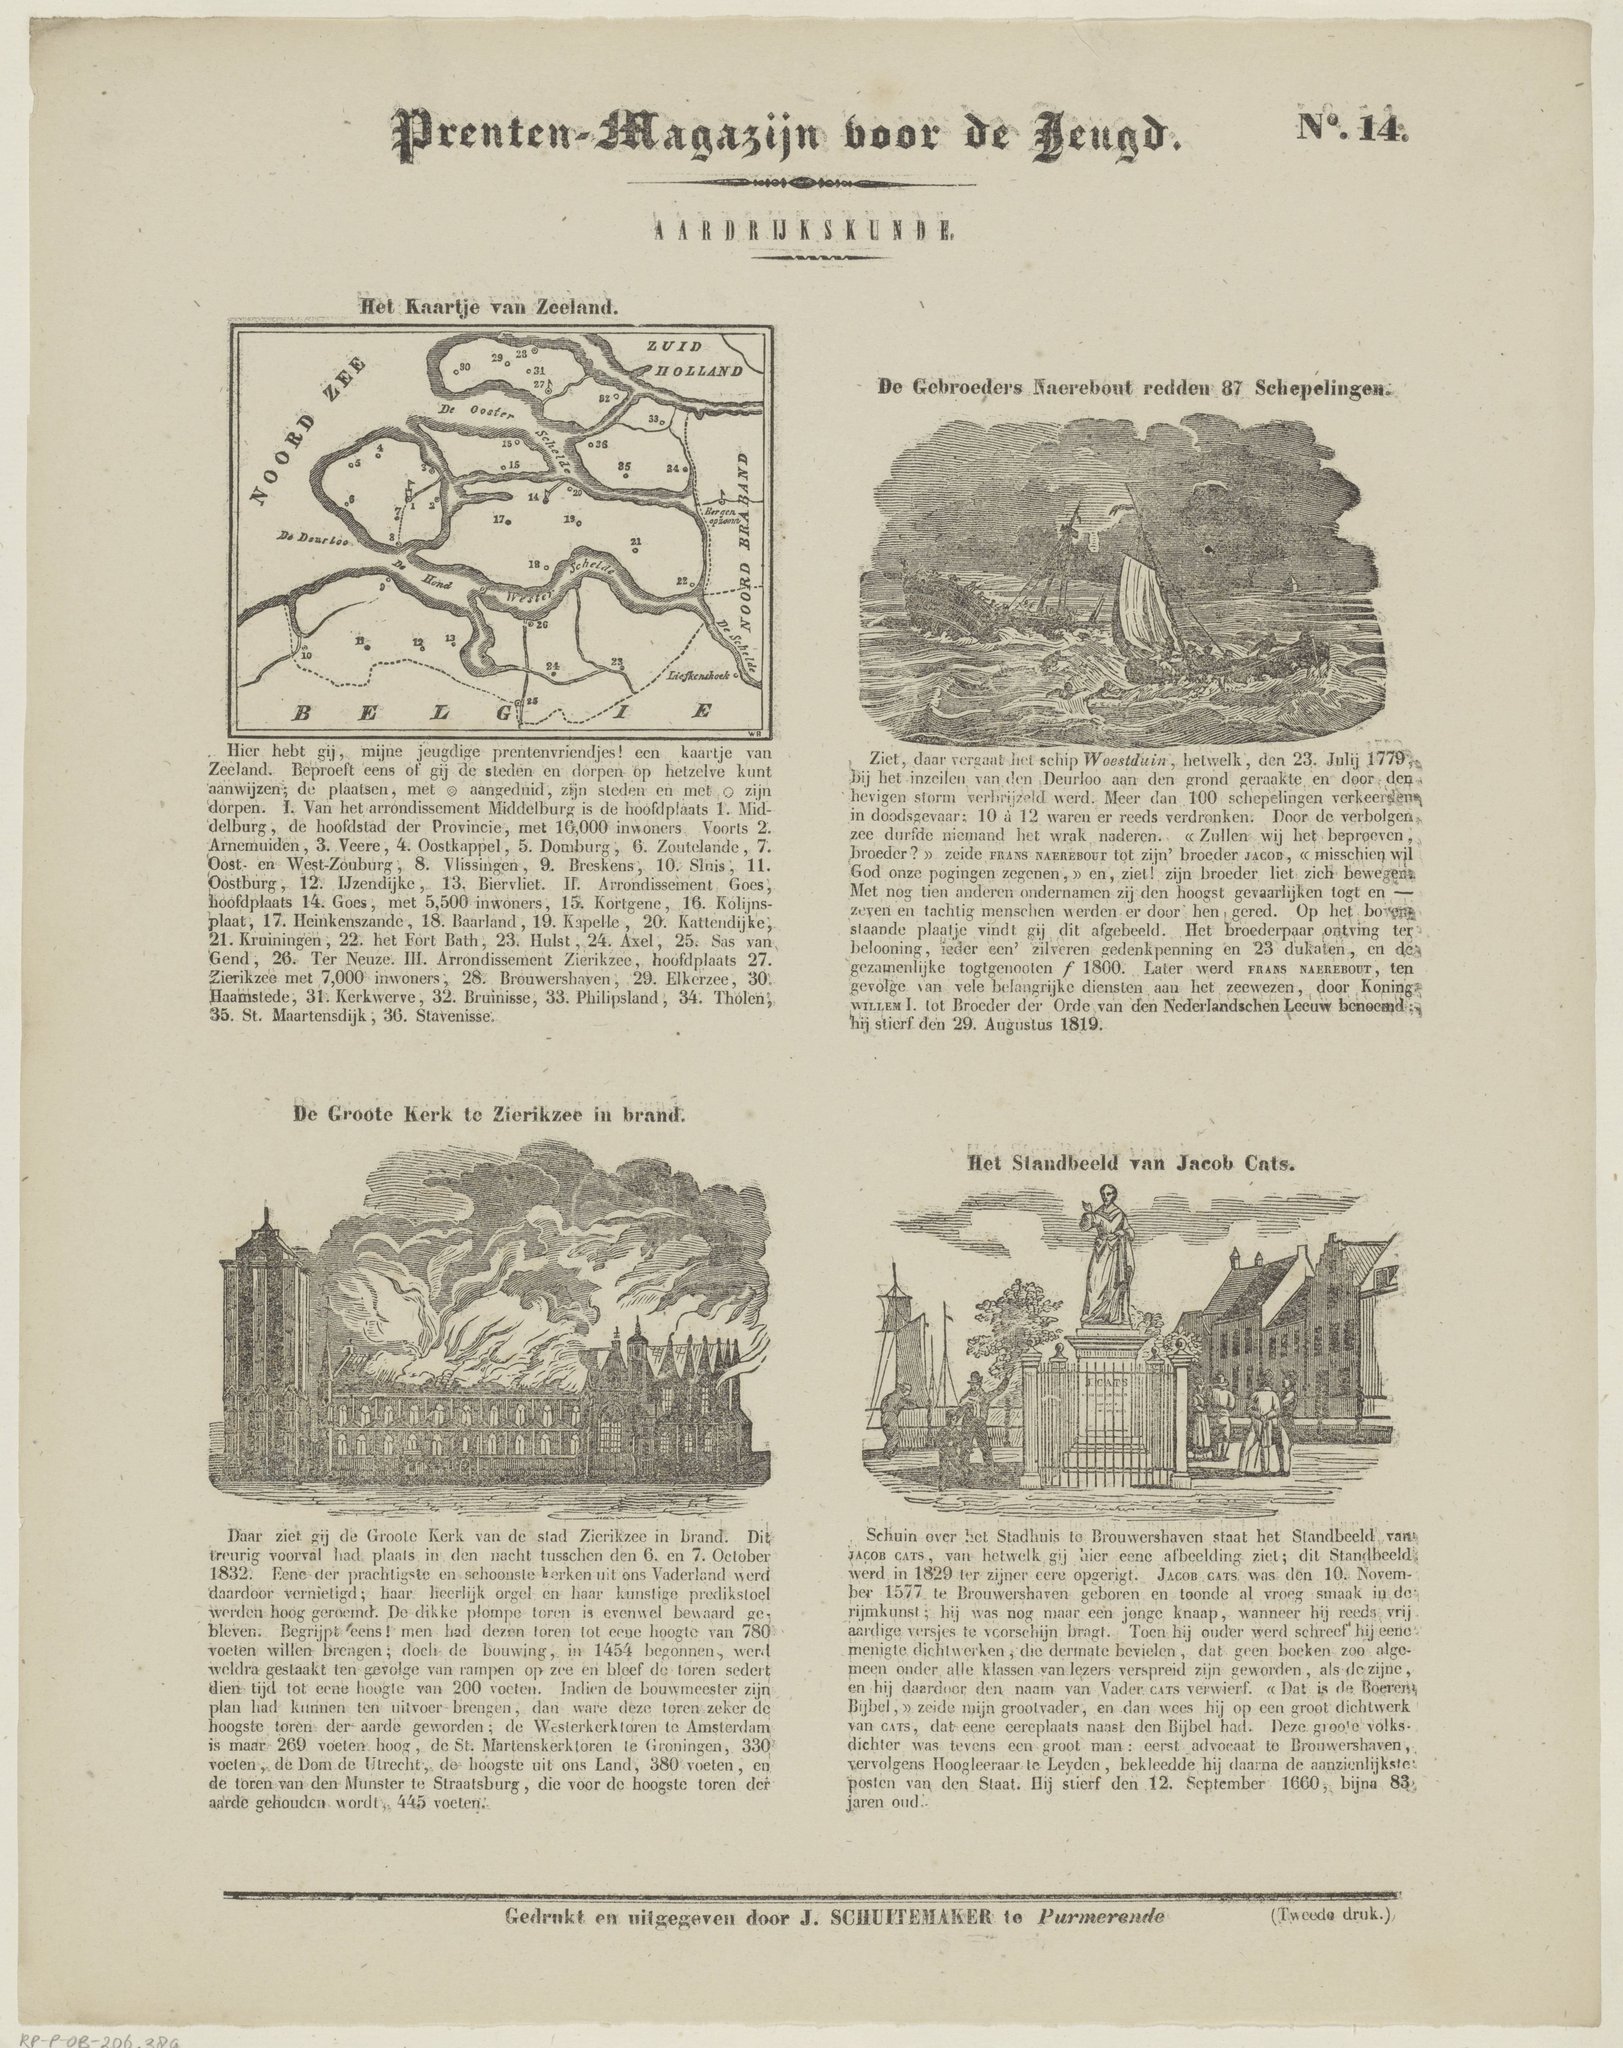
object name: popular print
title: De provincie Zeeland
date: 1842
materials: paper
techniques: letterpress printing, engraving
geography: netherlands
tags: the hague, jacob cats (1577-1660), maps, atlases, shipwreck, monument, statue, zeeland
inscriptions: collector's mark: Lugt 2760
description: Blad met 4 voorstellingen over de provincie Zeeland met een kaart en belangrijke gebeurtenissen en monumenten: de gebroeders Naerebout redden 87 schipbreukelingen, de brand in de Sint-Lievensmonsterkerk te Zierikzee in 1832 en het standbeeld van Jacob Cats in Brouwershaven. Boven elke voorstelling een titel en onder elke voorstelling een onderschrift. Genummerd rechtsboven: No. 14.